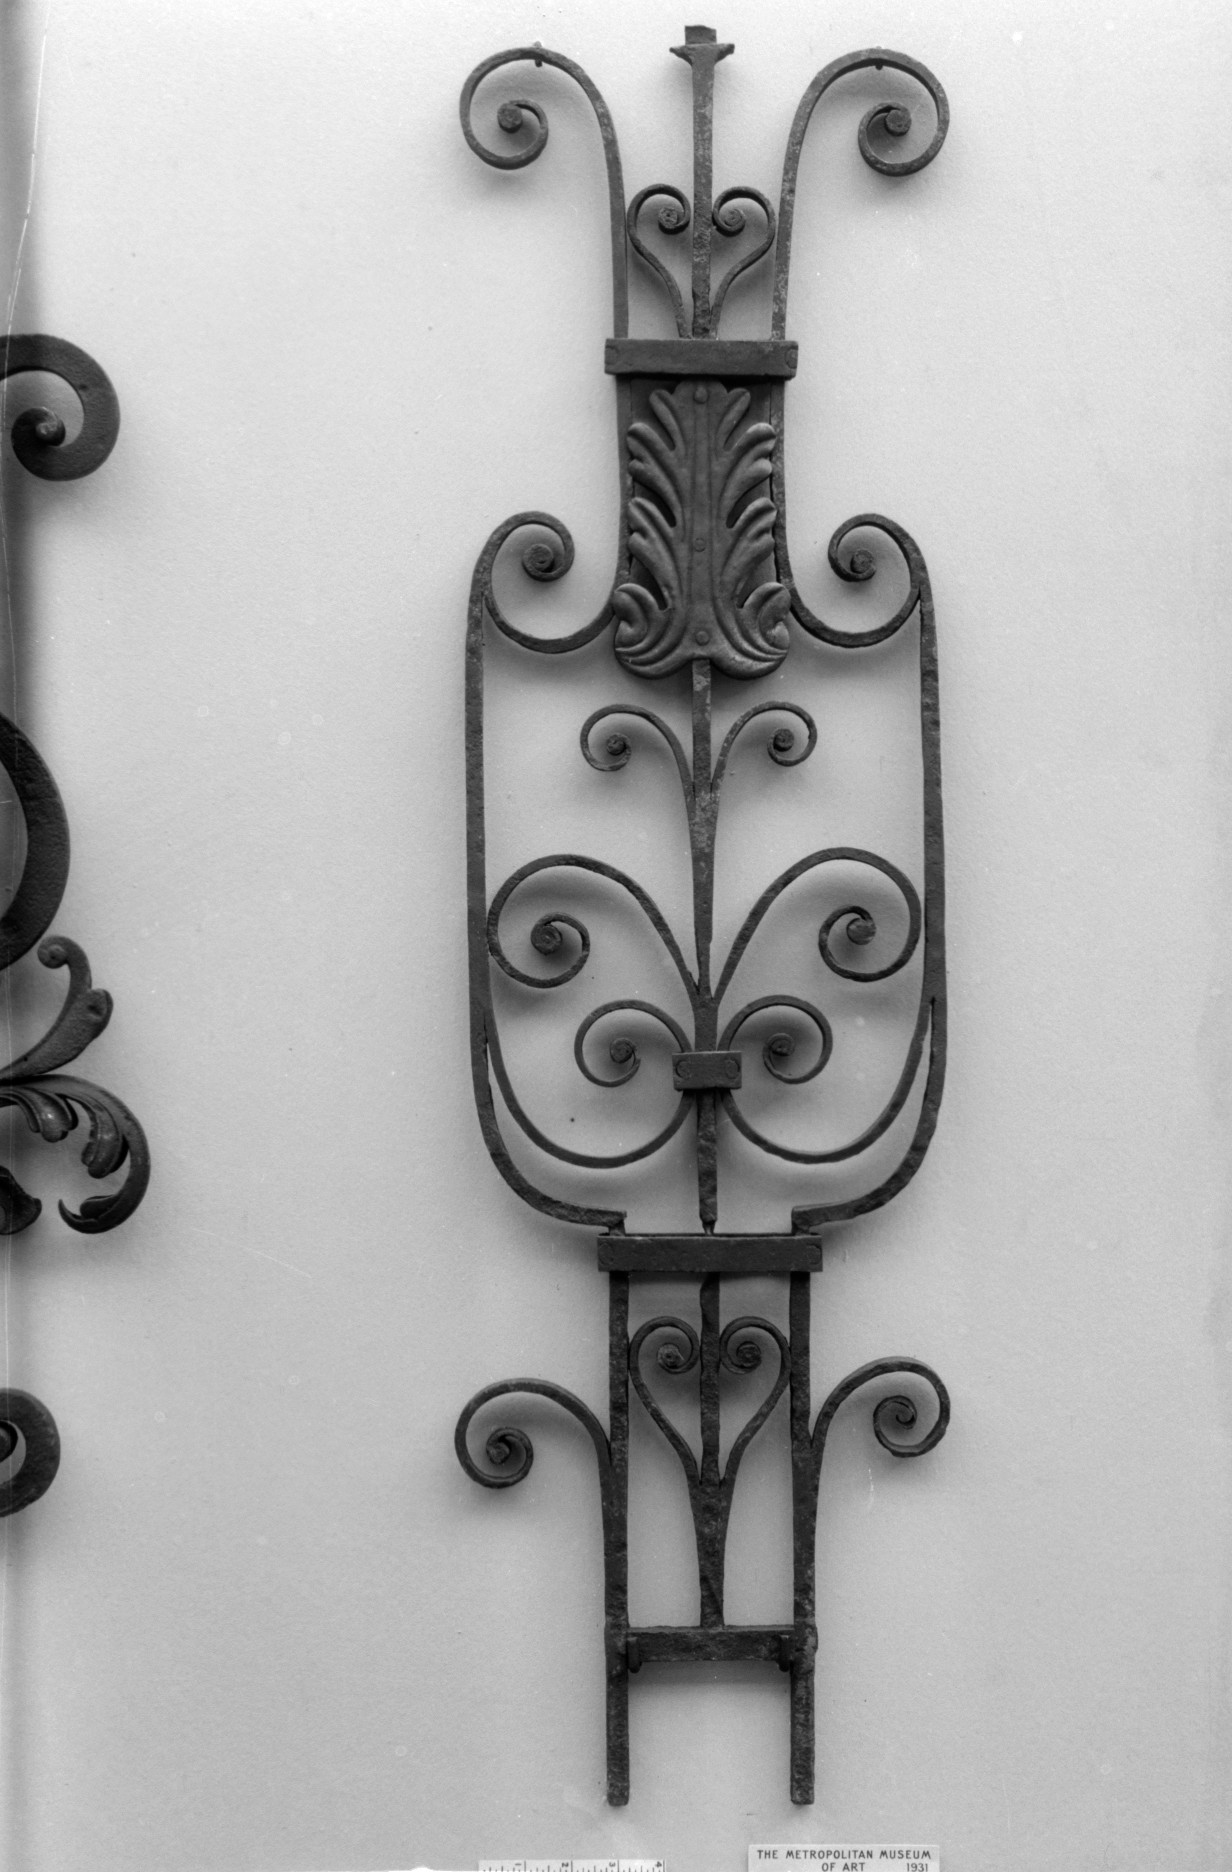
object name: baluster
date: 1750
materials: iron